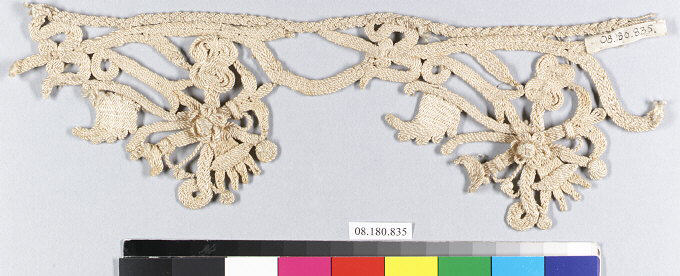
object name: trimming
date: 1801-1900